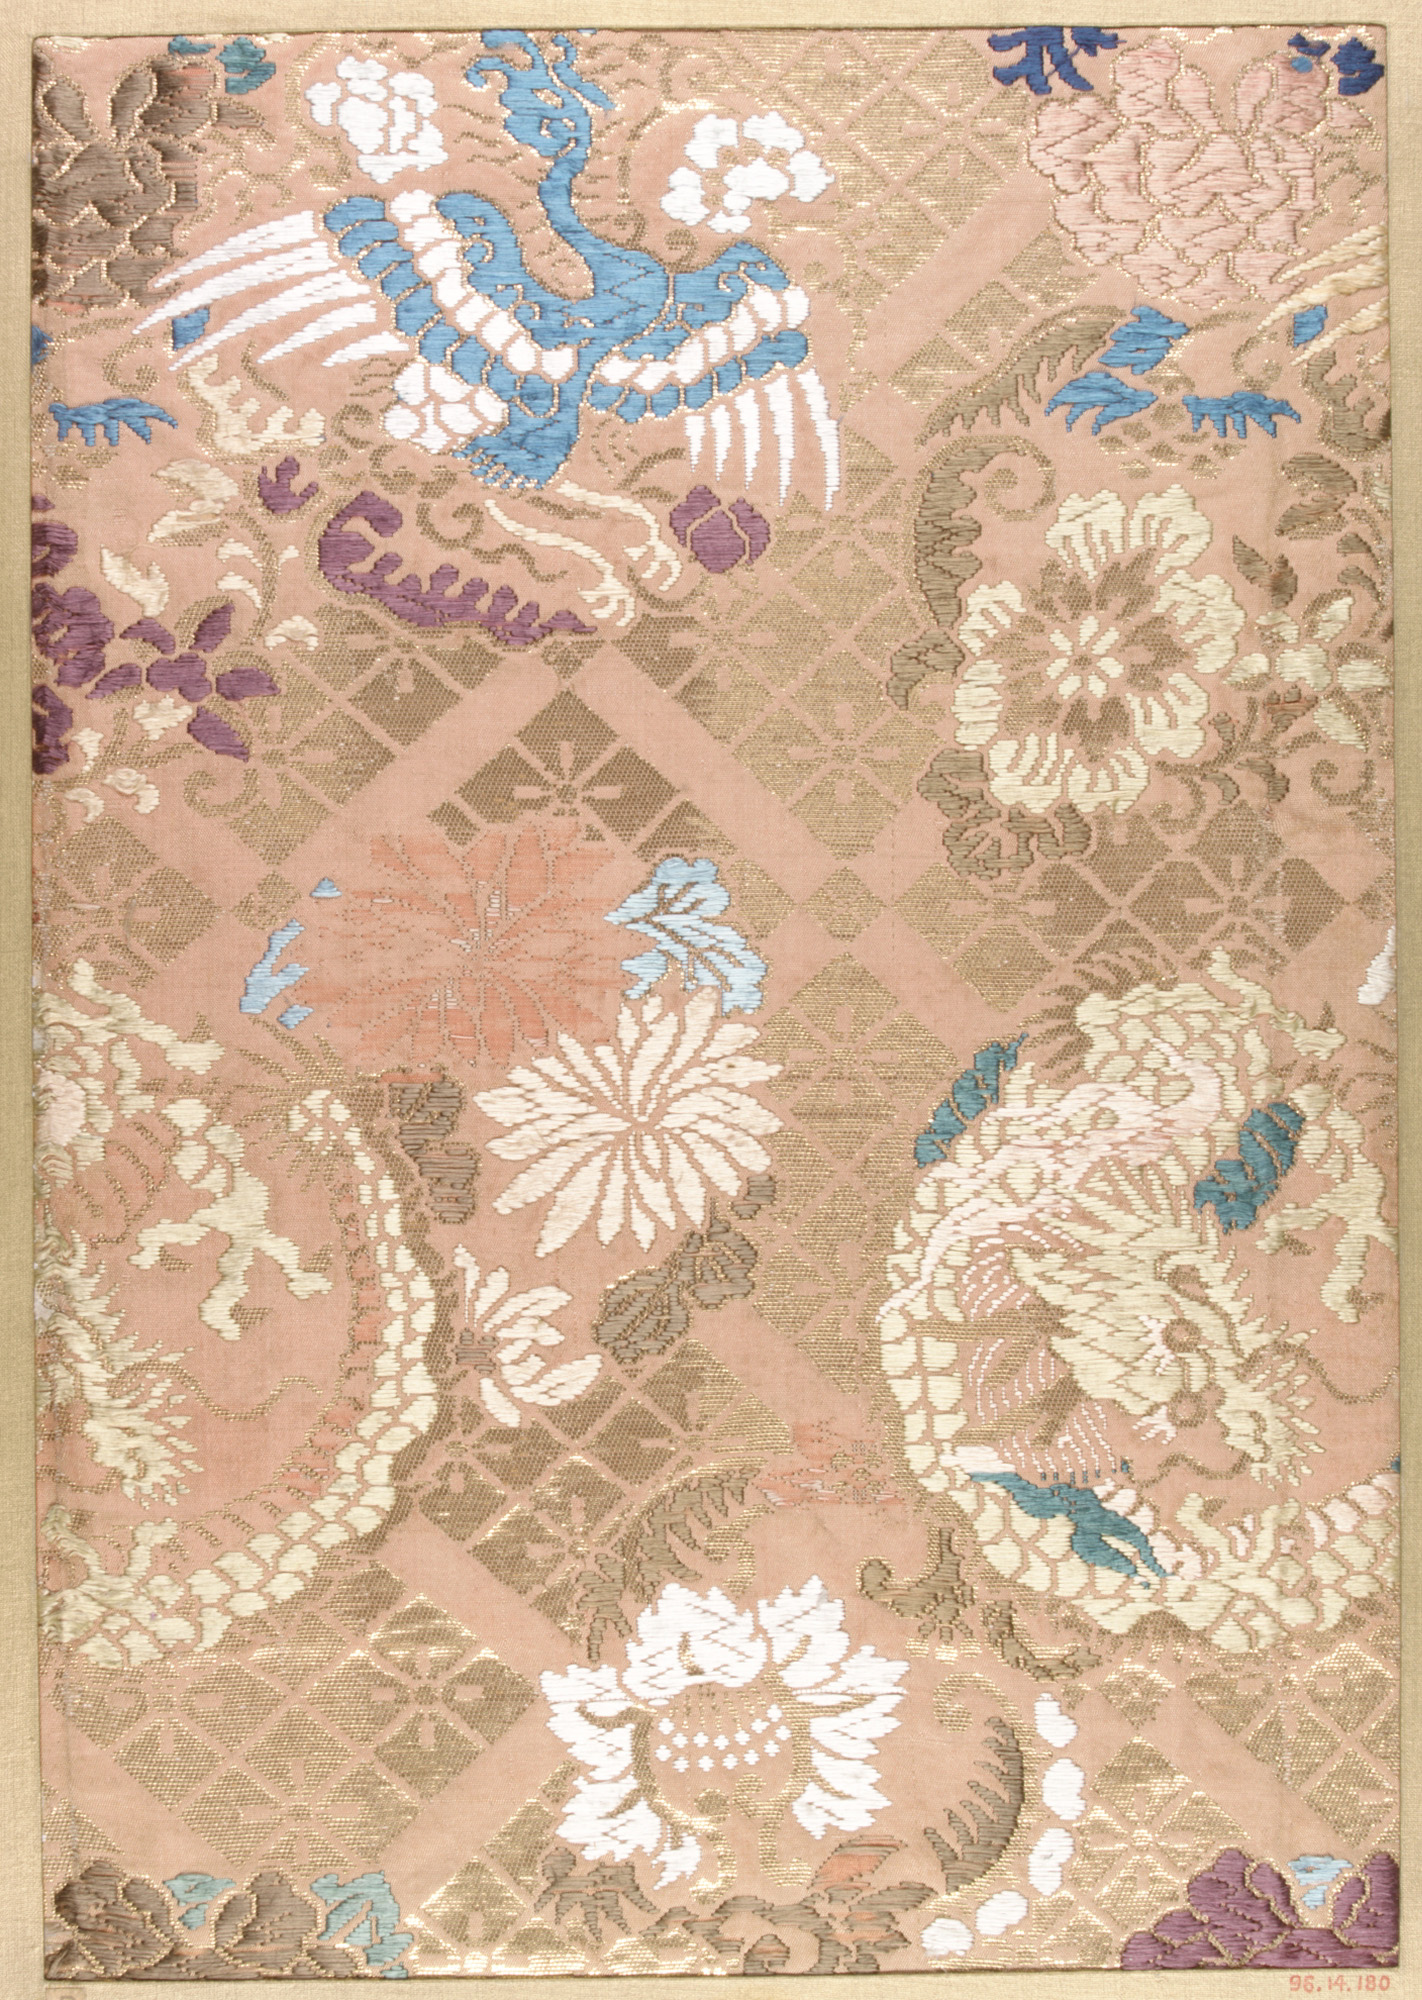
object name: piece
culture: japanese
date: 1701-1900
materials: silk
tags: birds